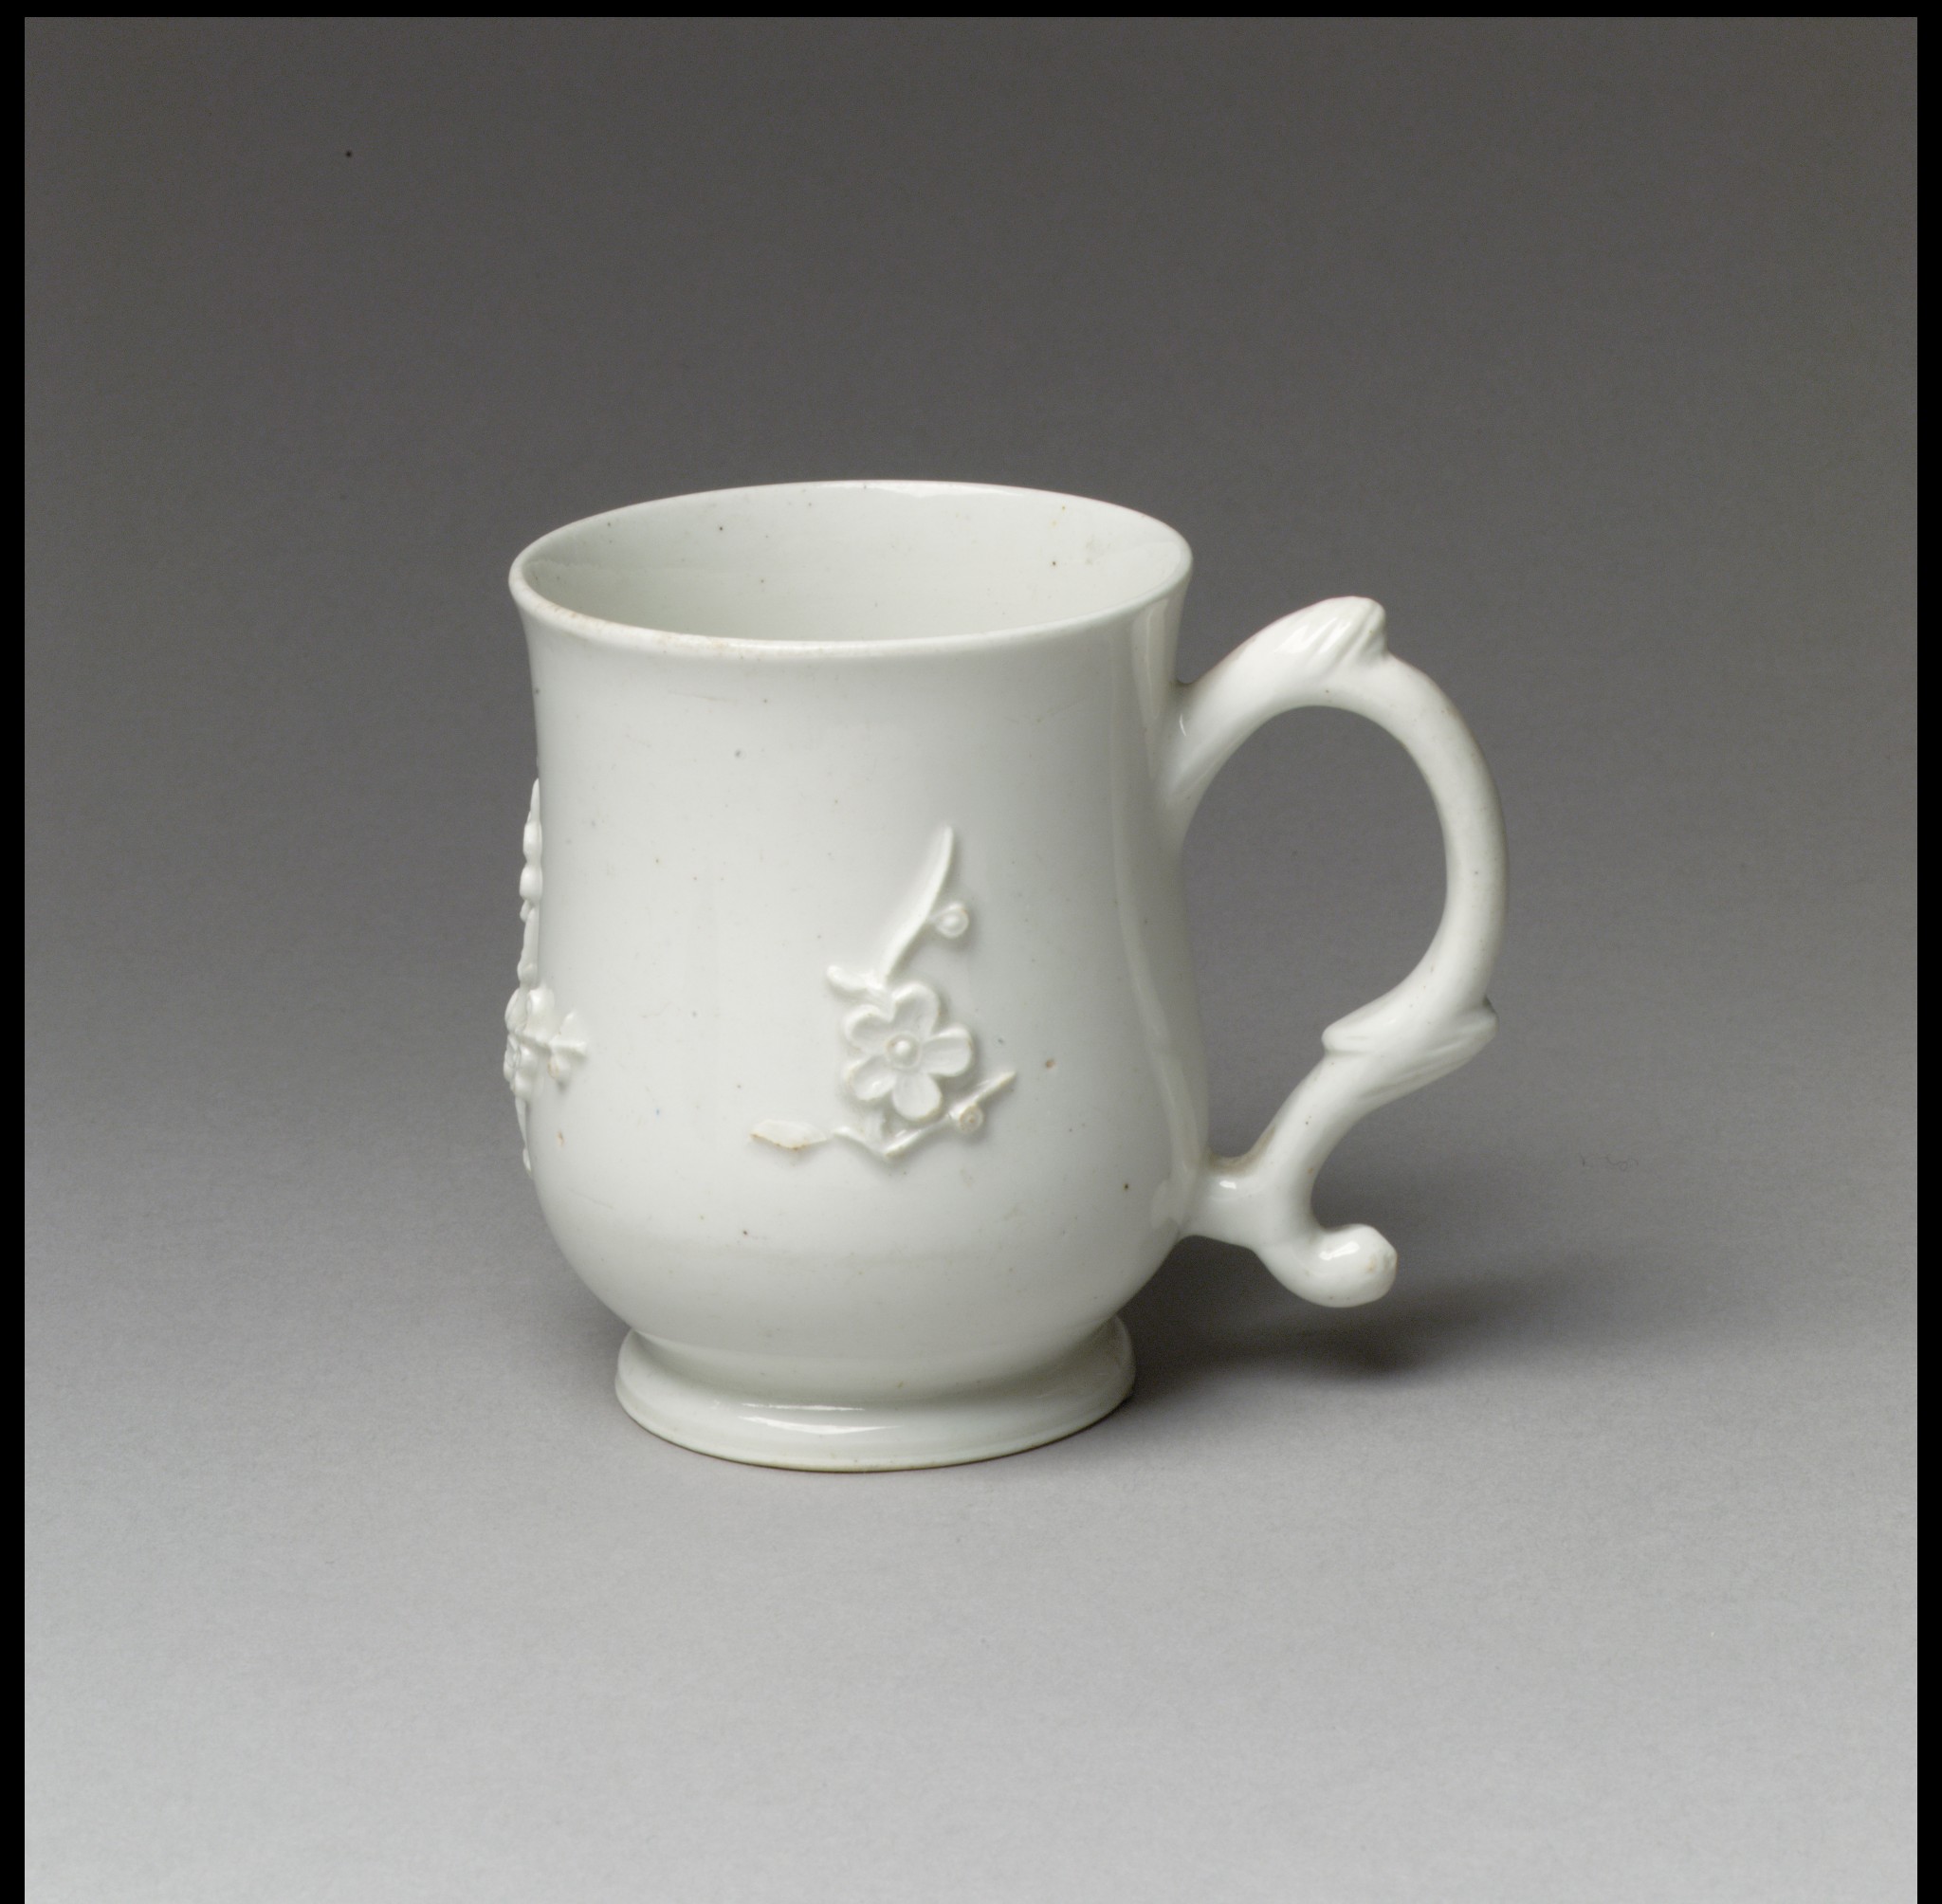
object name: mug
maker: bow porcelain factory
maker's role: factory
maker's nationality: british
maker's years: 1747-1776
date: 1750-1755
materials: soft paste porcelain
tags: flowers